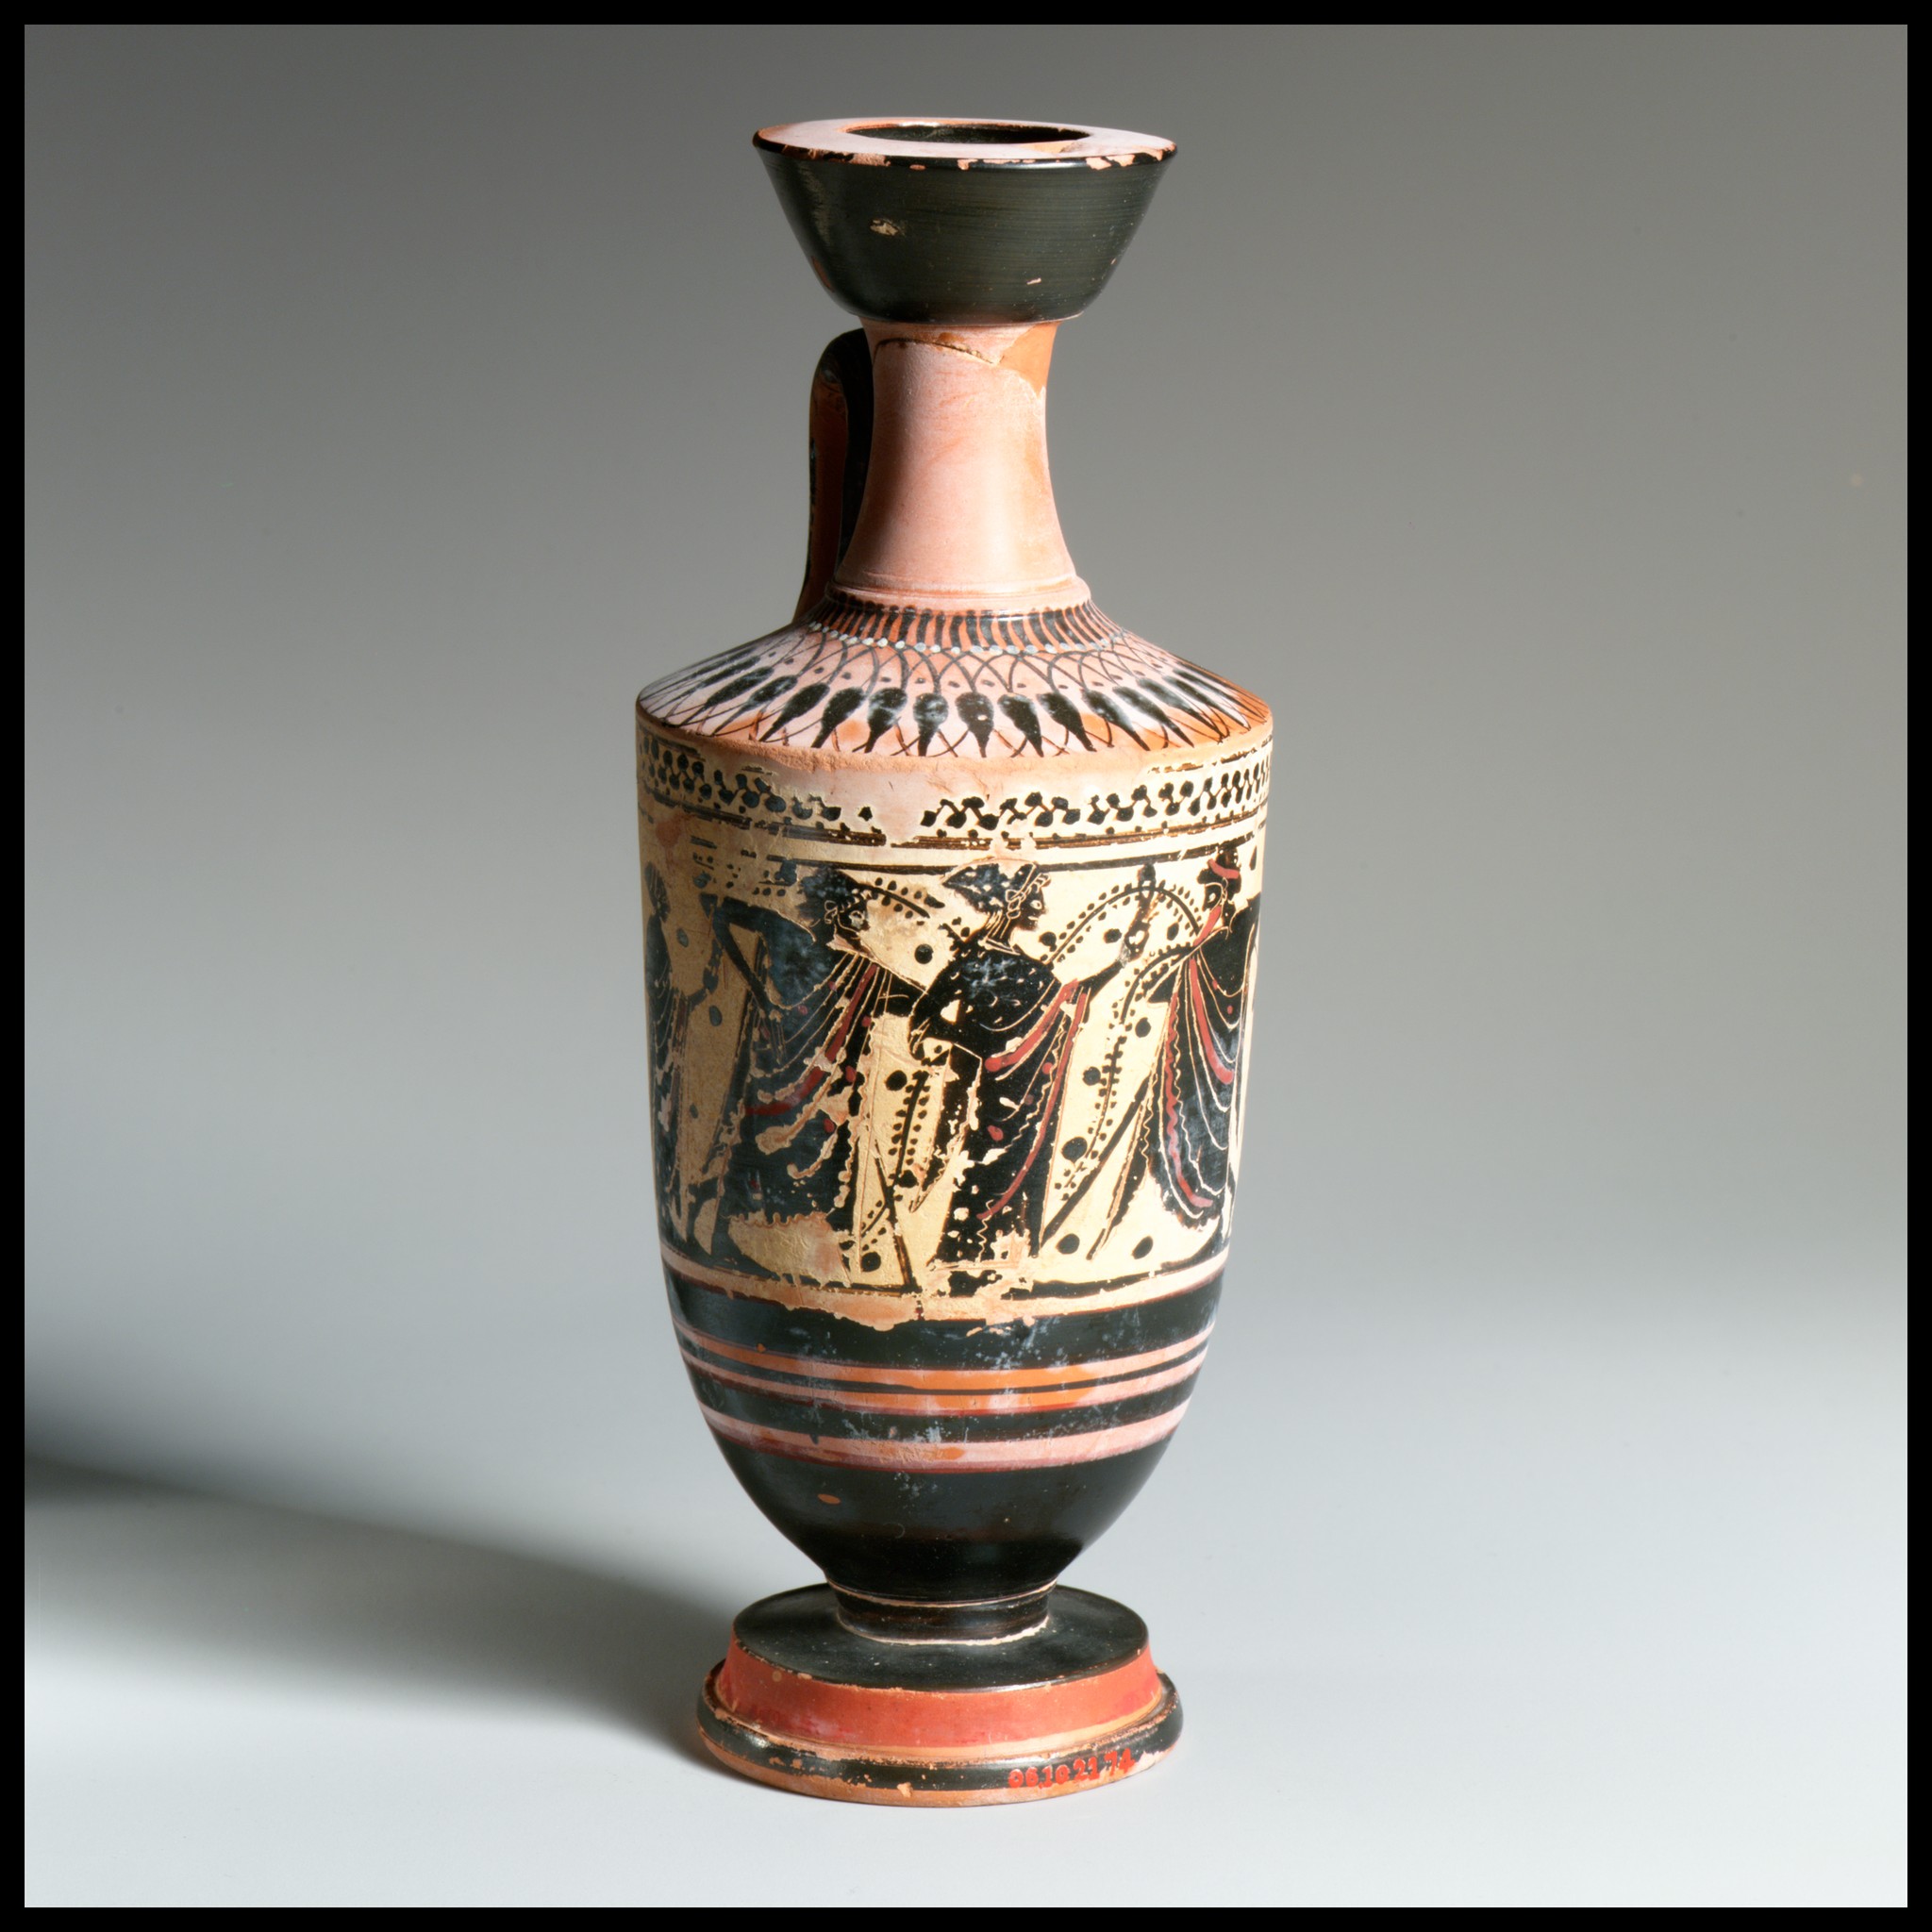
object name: lekythos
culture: greek, attic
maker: emporion painter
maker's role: artist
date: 500 BCE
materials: terracotta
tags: men,women